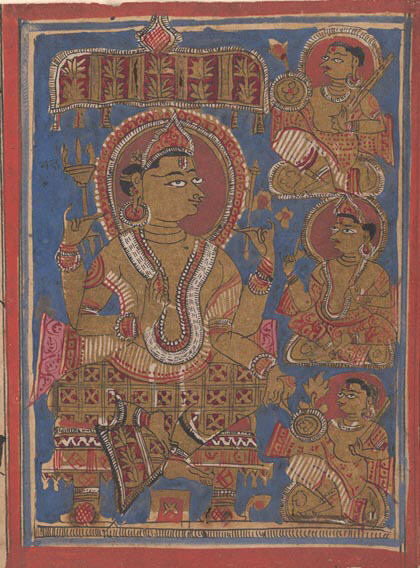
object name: folio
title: Shakra Enthroned, with a Deva and Generals: Folio from a Kalpasutra Manuscript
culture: indian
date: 1401-1500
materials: gold, ink, paper, watercolor